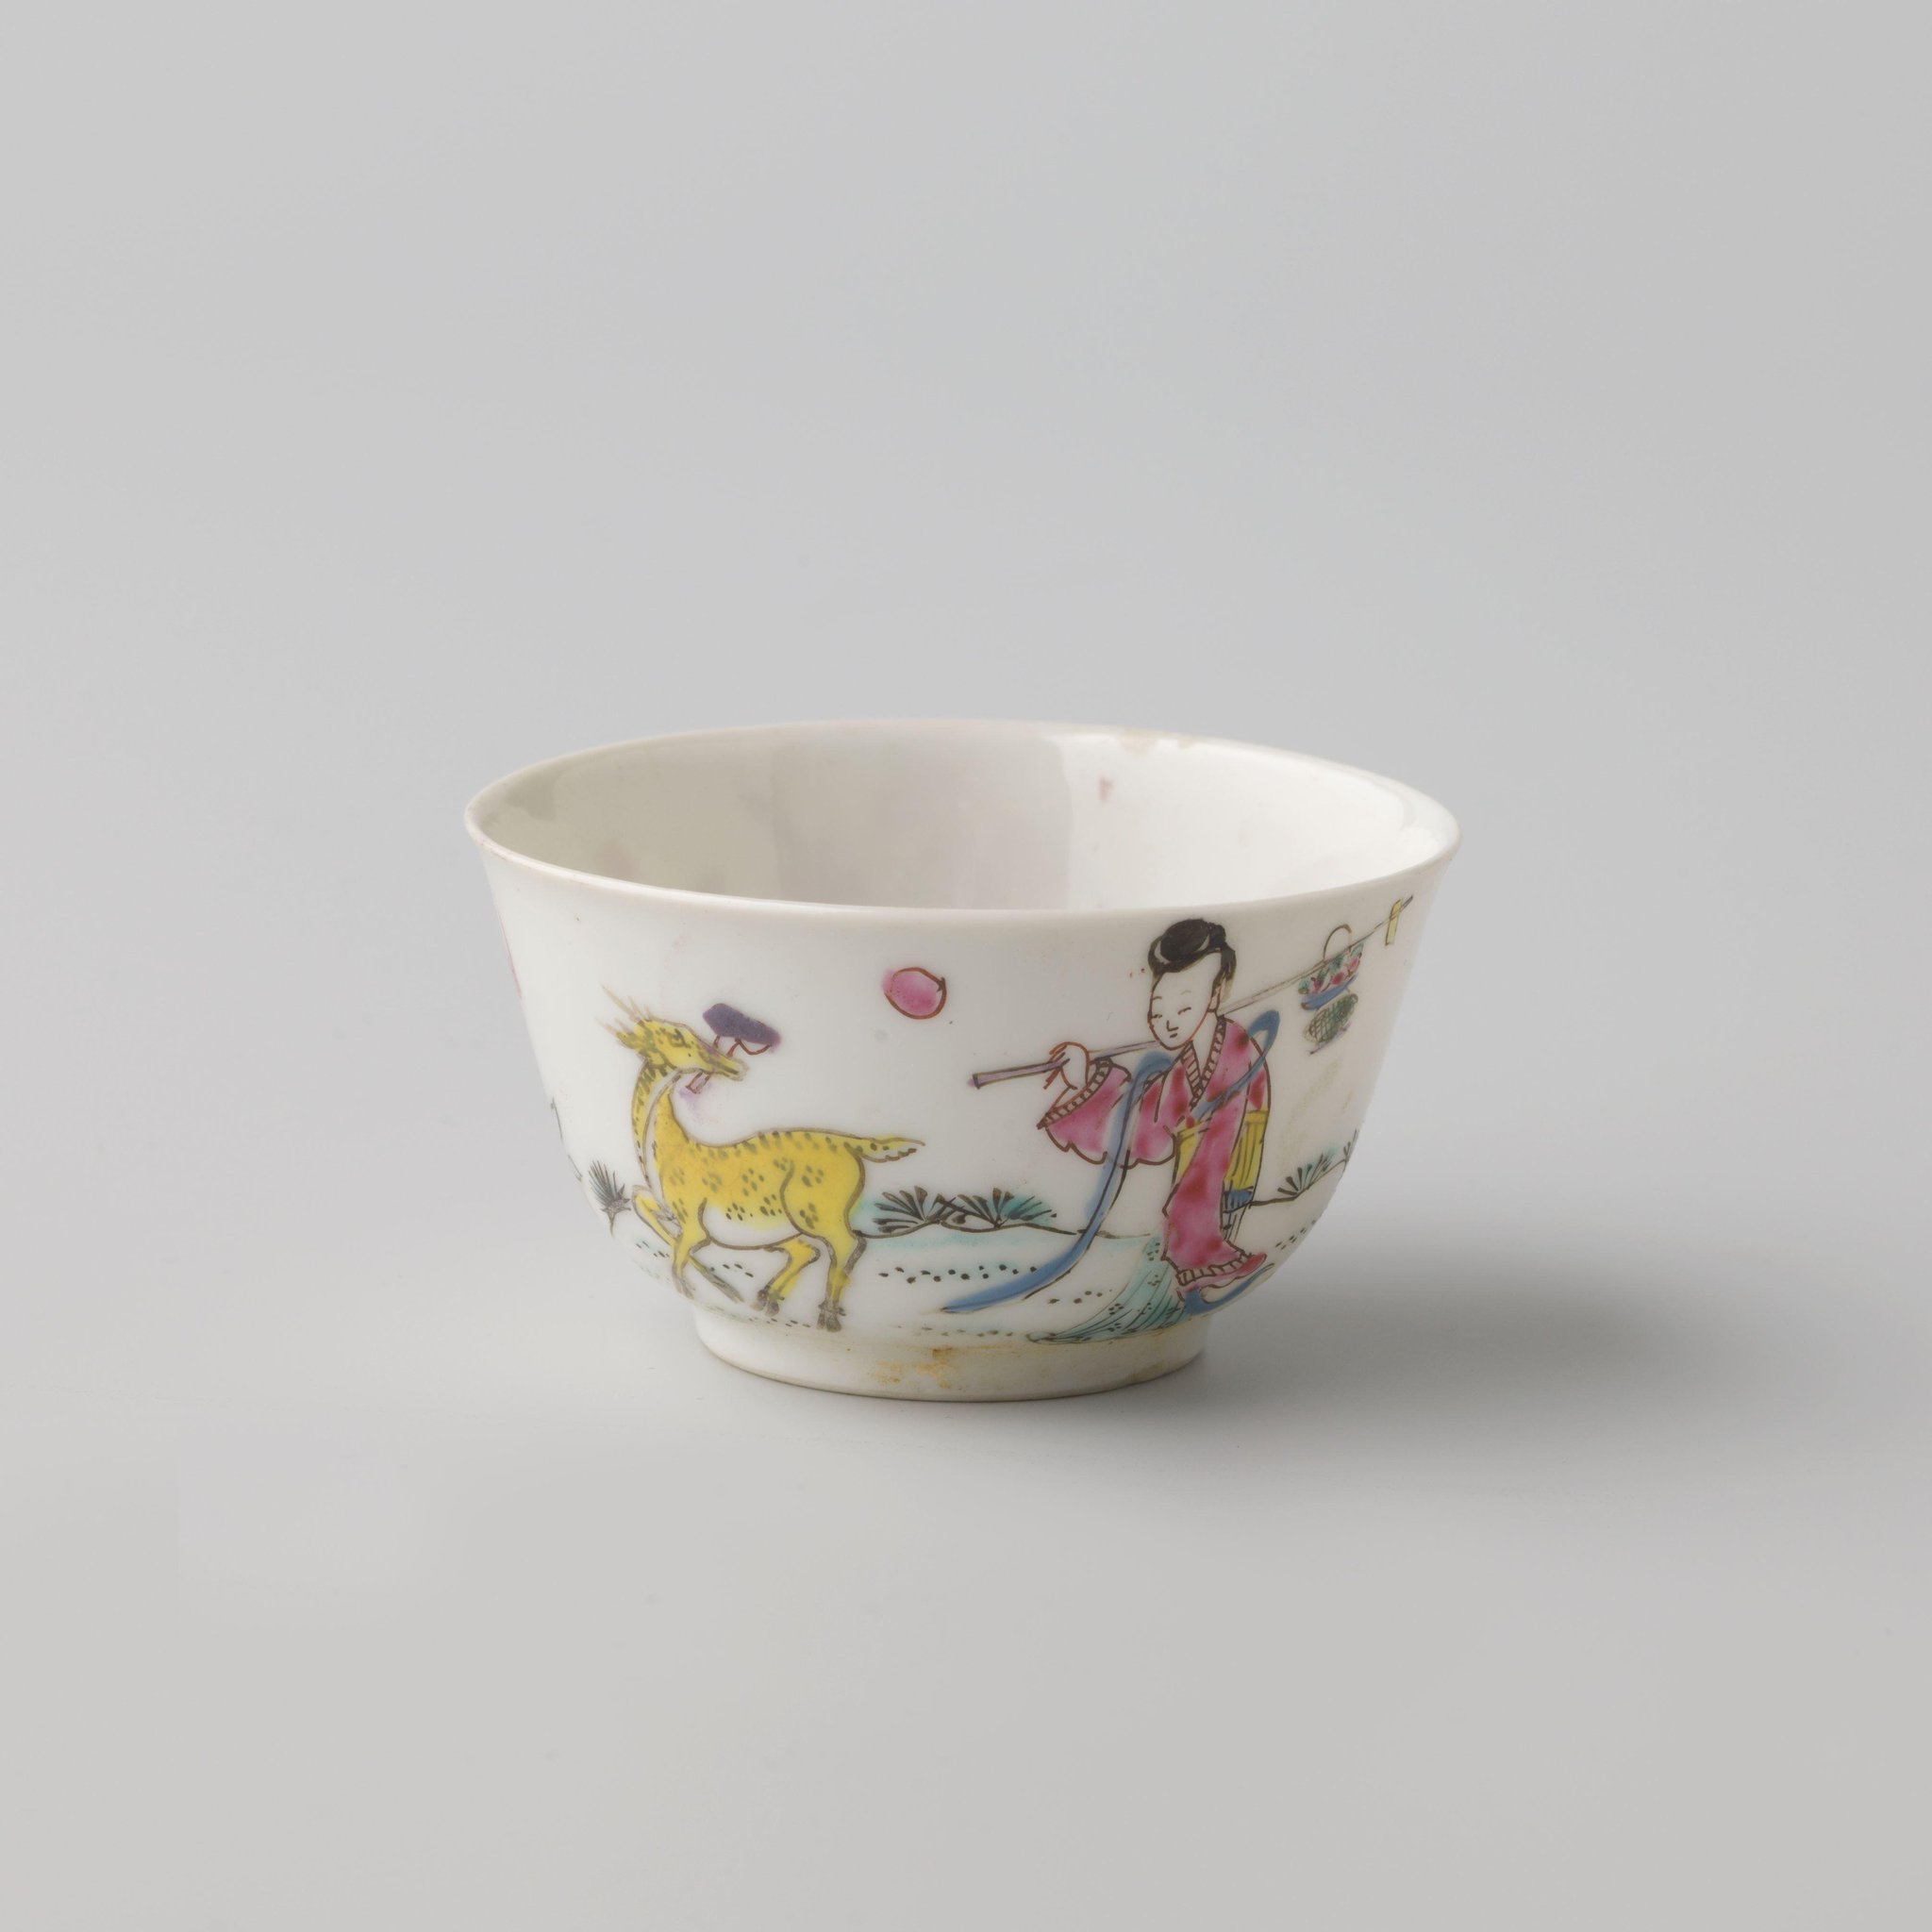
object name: platter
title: Saucer with Lan Caihe in a landscape with a deer and bat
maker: Anonymous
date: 1725-1749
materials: glaze, paint, porcelain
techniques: firing, turning, vitrification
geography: china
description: Schotel van porselein, beschilderd op het glazuur in blauw, rood, roze, groen, geel en zwart. Op het plat van de schotel een voorstelling van Lan Caihe (Lan Ts'ai Ho) met zijn fruitmand in een landschap bij een rots en een prunus; naast hem ligt een hert met een paddenstoel (lingzhi) in zijn bek en vliegt een vleermuis. Een barst en een chip in de rand van de schotel. Famille rose met famille verte.